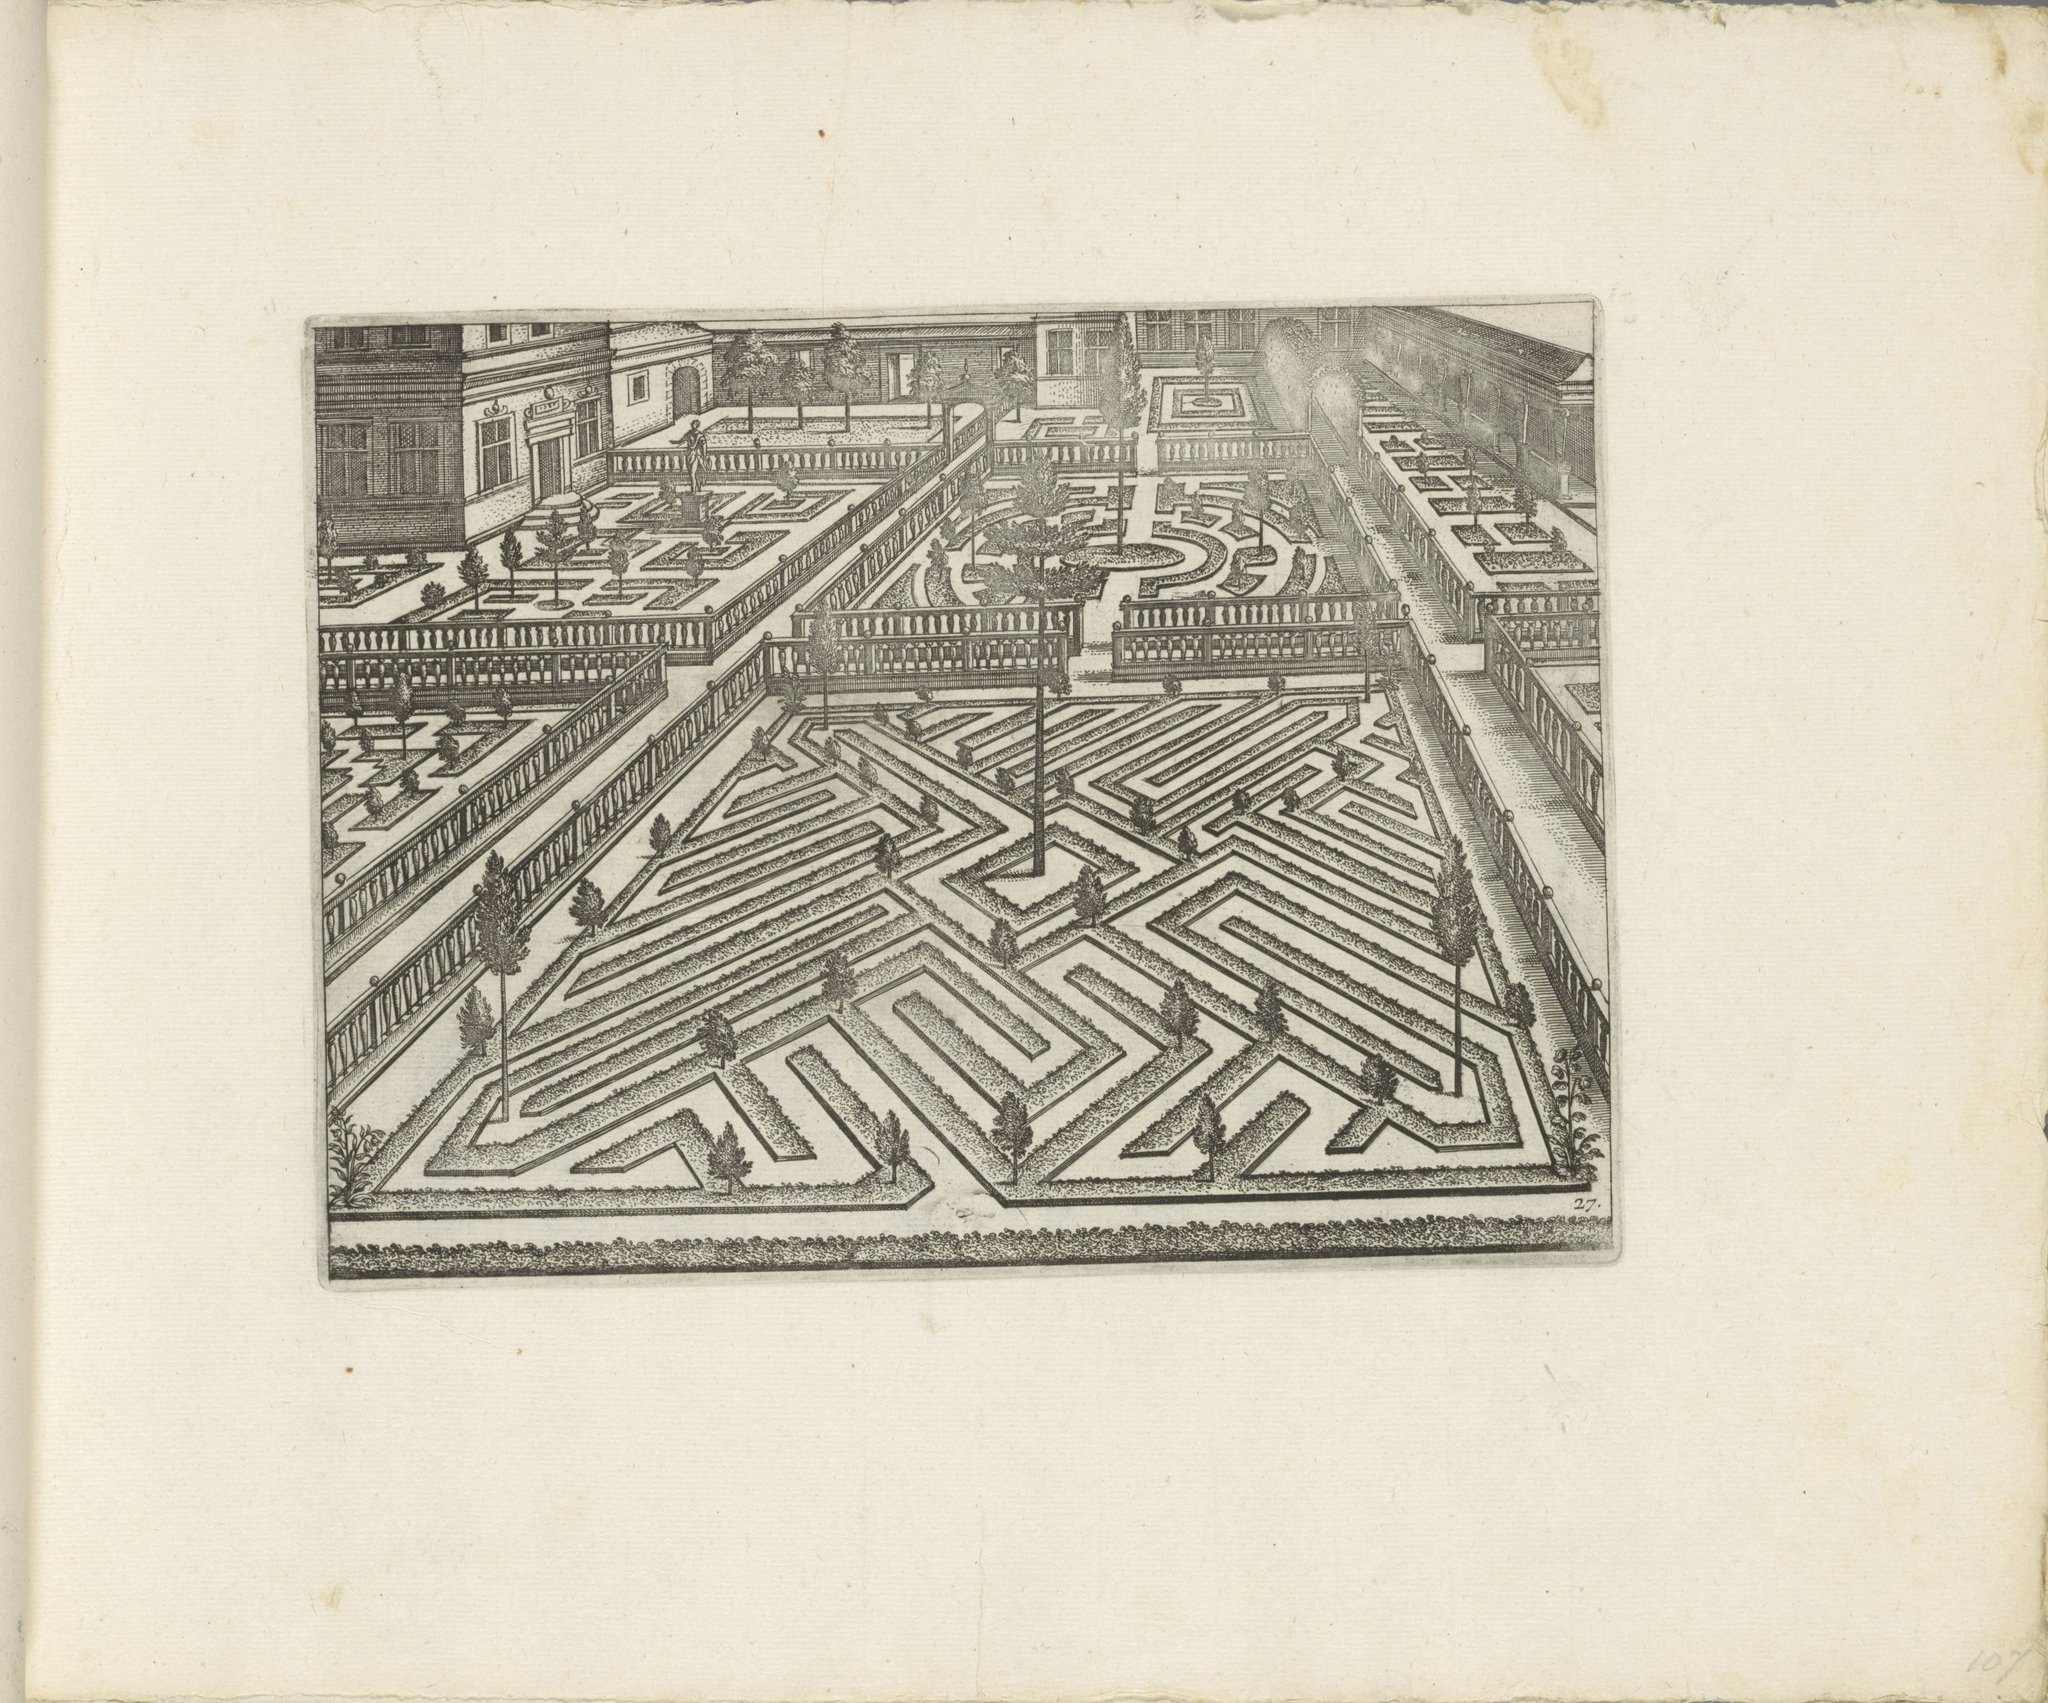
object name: print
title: Hortorum Viridariorumque (...)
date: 1587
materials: paper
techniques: etching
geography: antwerp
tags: garden, french or architectonic garden; formal garden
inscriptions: collector's mark: Lugt 2228, collector's mark: Lugt 2760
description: De serie ‘Hortorum Viridariorumque’ van Vredeman de Vries (Hollstein Dutch 470-490) is in deze editie van de serie door uitgever Joannes Galle ( en eerder door zijn voorganger Theodoor Galle) aangevuld met de serie ‘Tuinen’ van Vredeman de Vries (Hollstein Dutch 508-515) en met twee prenten van Pieter van der Borcht (I) (New Hollstein Dutch 161-162). De prenten zijn genummerd: 1-30. Origineel hoort bij deze editie van de serie, uitgegeven door Joannes Galle, nog een prent van Van der Borcht met nummer 31, maar deze prent ontbreekt in deze serie in de collectie van het Rijksmuseum.